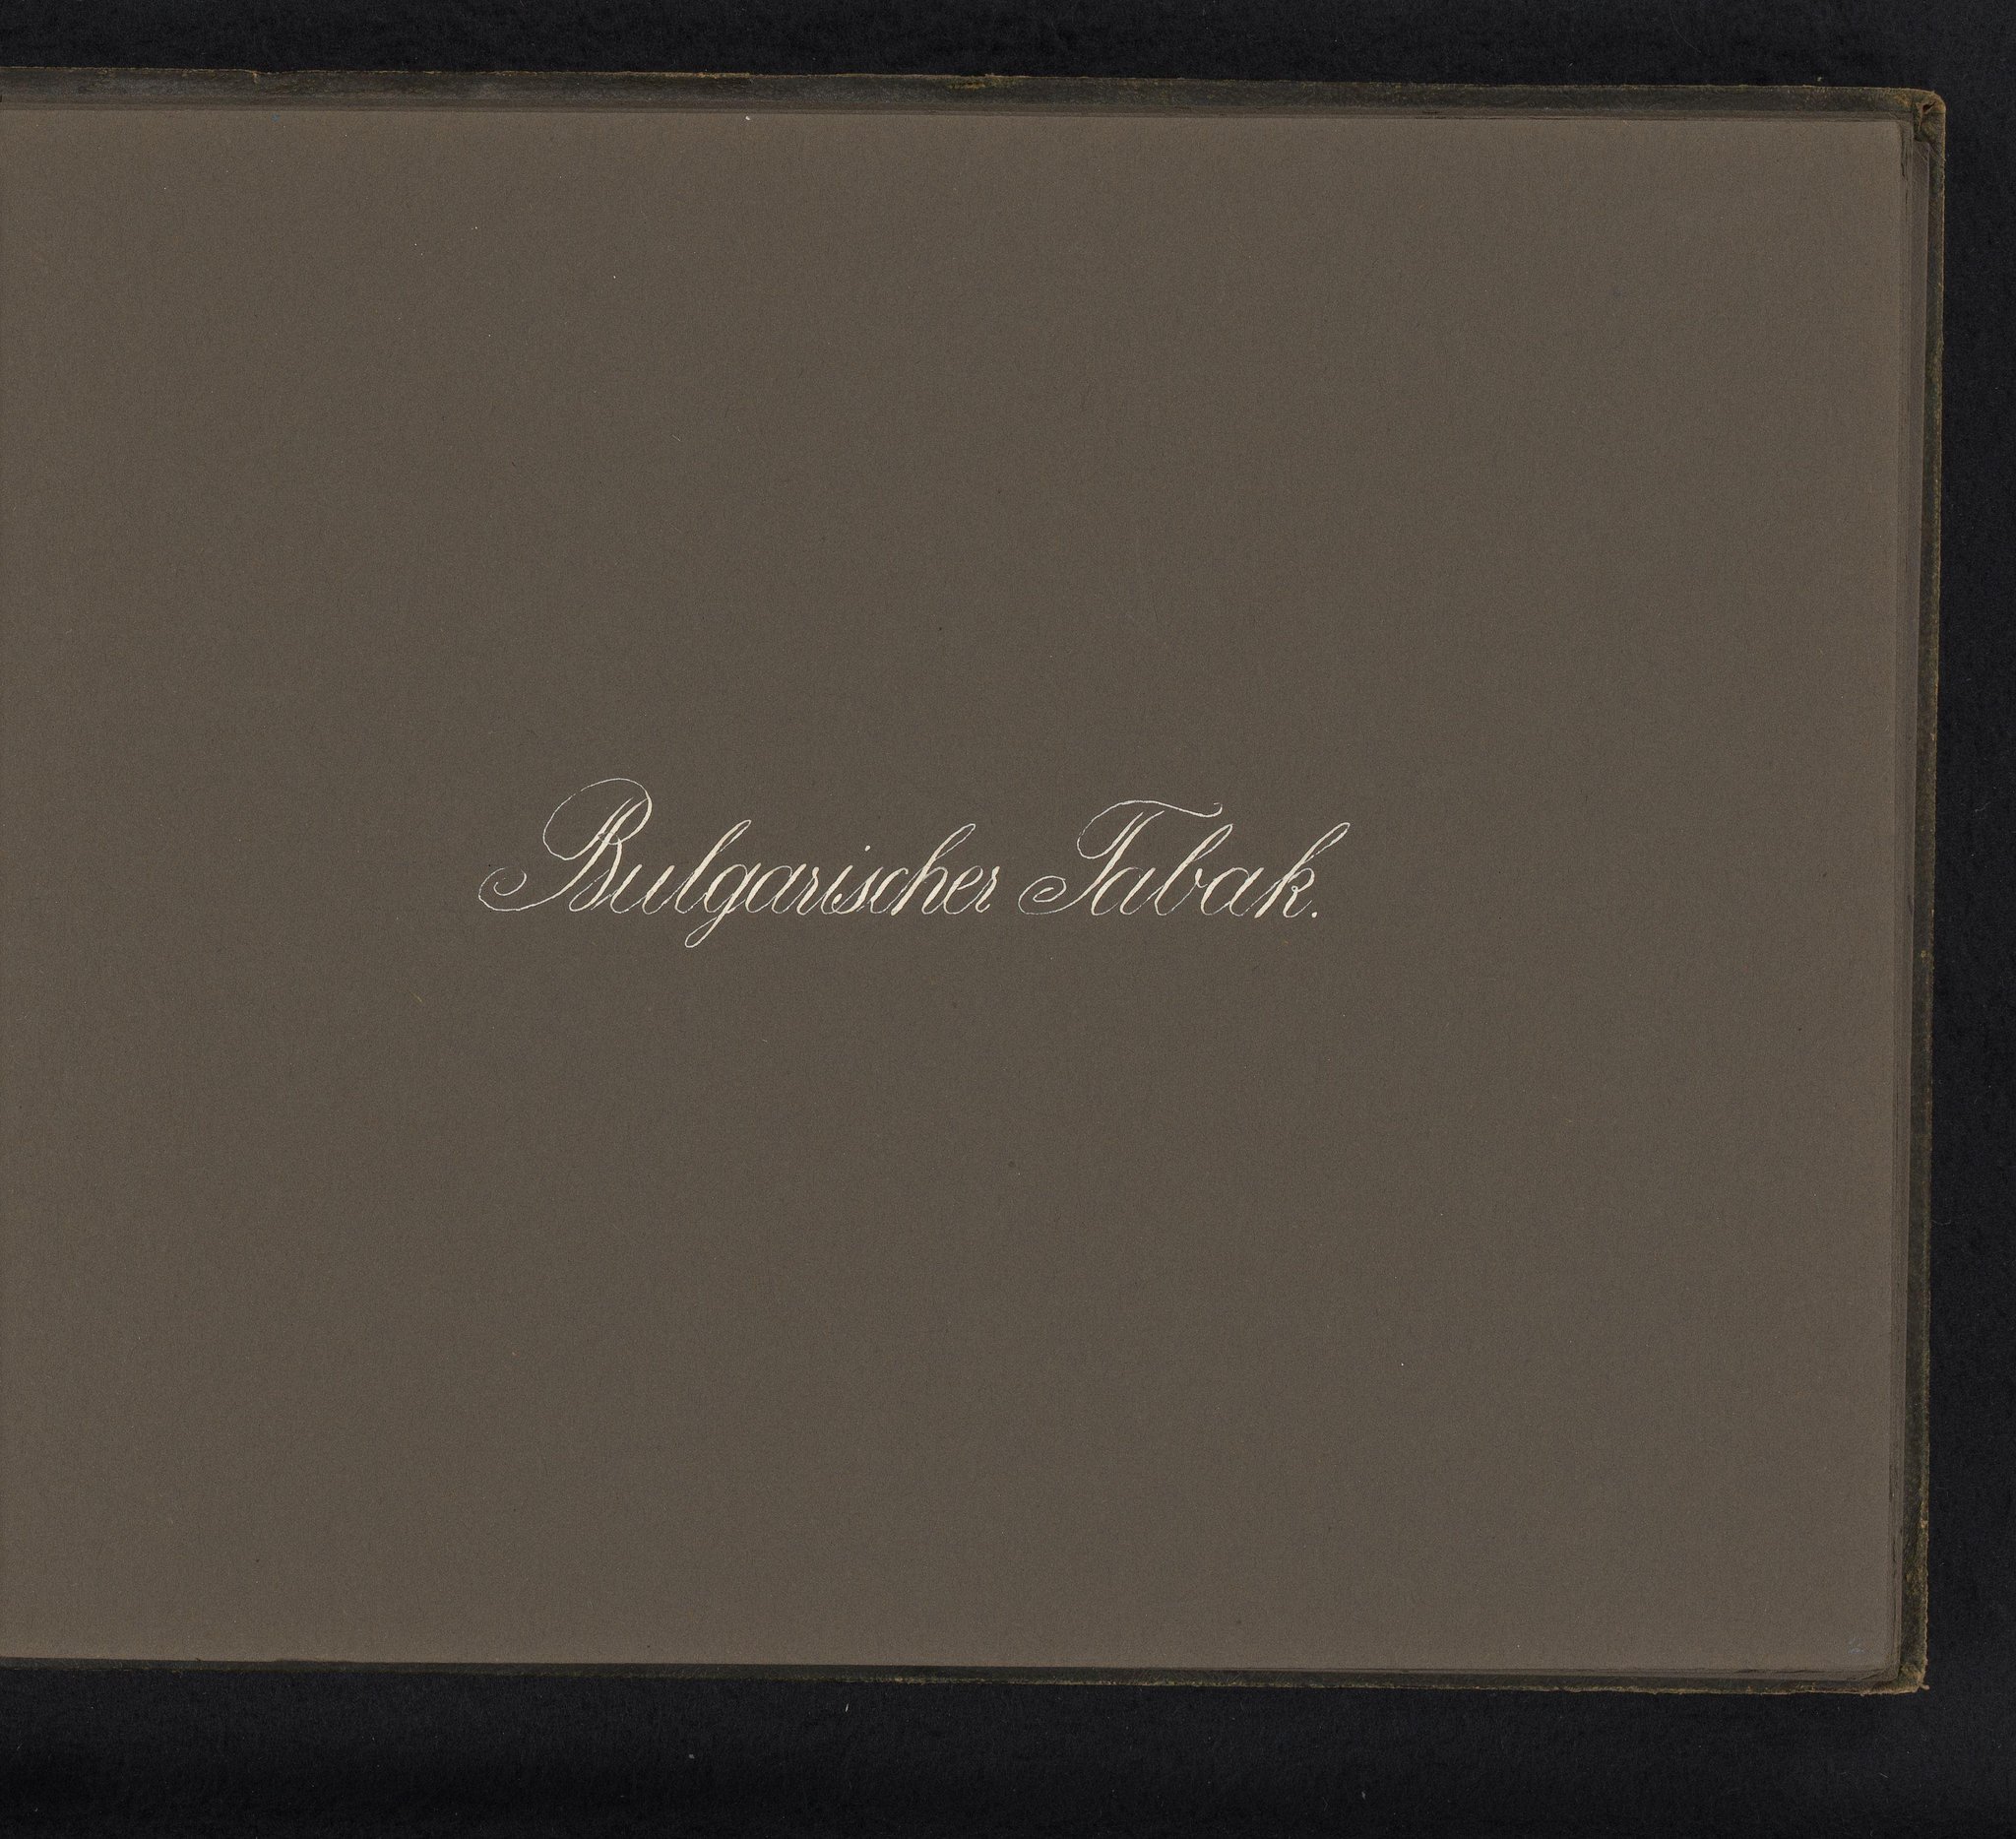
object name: album leaf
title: Bulgarischer Tabak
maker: Anonymous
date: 1912-1928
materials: cardboard, ink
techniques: pen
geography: sofia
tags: eugen wachenheimer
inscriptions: date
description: Handgeschreven titel voorin het album. Onderdeel van het fotoalbum voor Eugen Wachenheimer bij zijn afscheid als directeur van het filiaal van de Deutsche Bank in Sofia, december 1928.